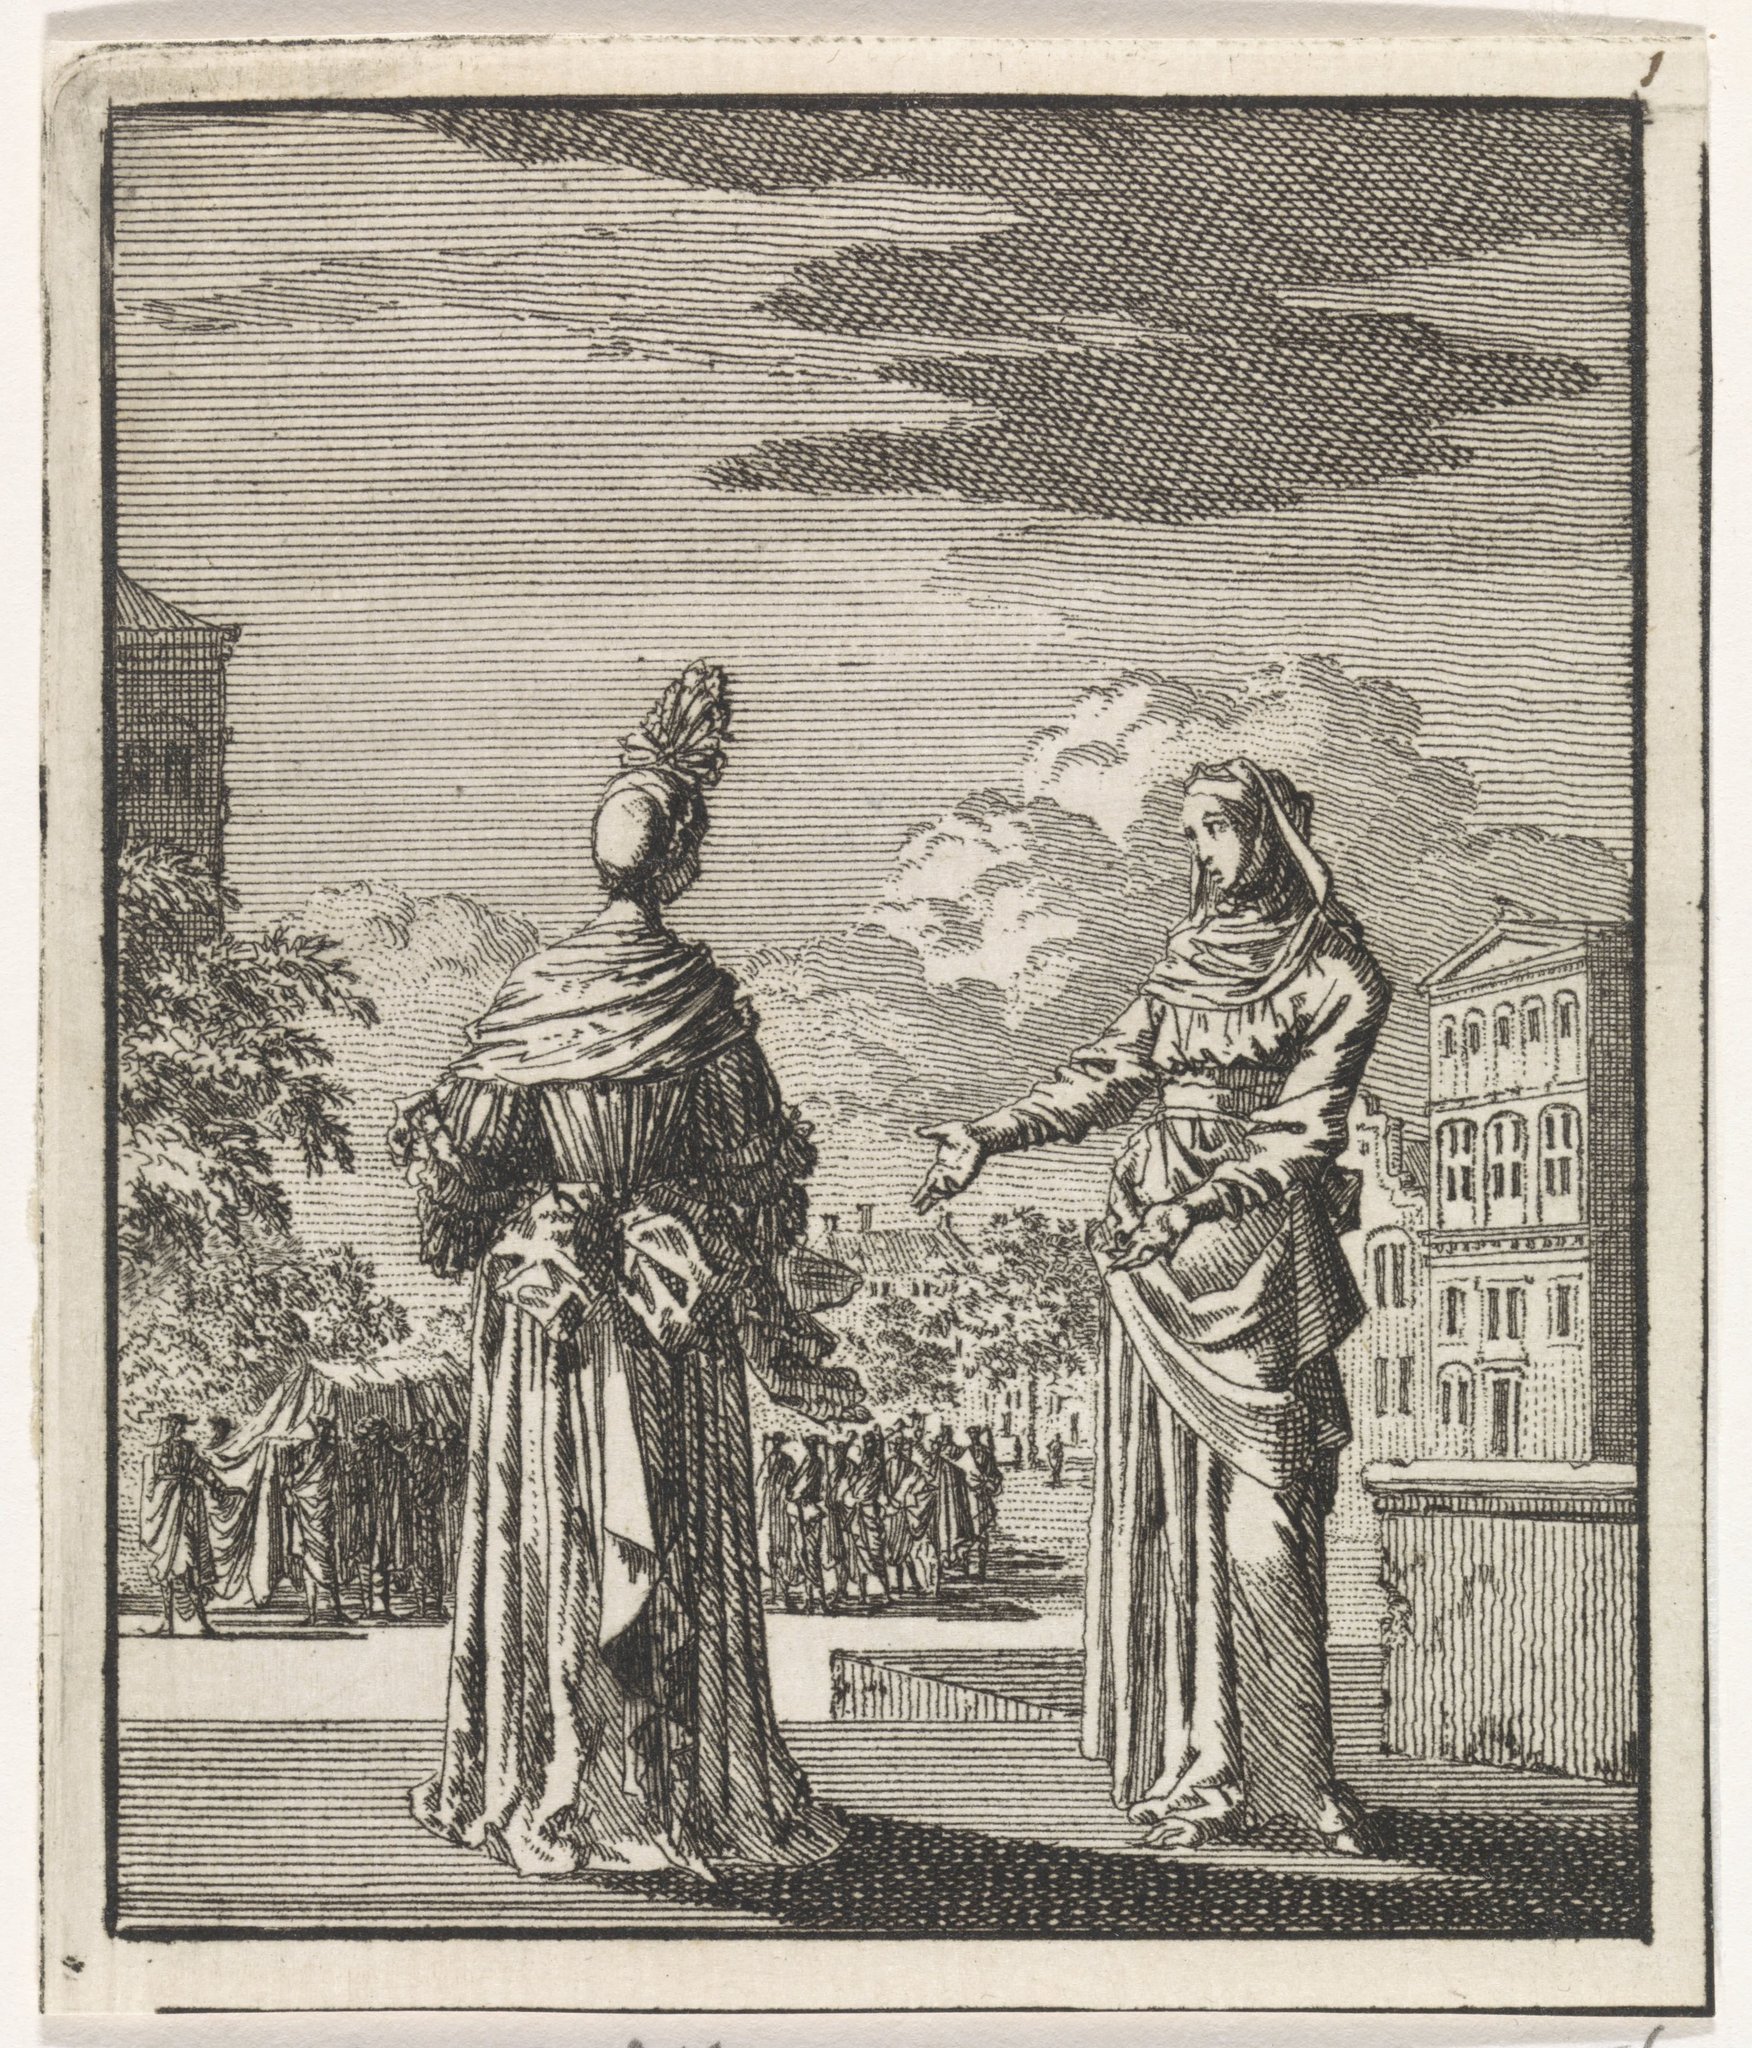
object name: print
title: Vrouw wijst dame op een voorbijtrekkende begrafenisstoet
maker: jan luyken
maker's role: draughtsman, print maker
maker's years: 1649-1712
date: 1704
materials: paper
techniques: etching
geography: amsterdam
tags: cortege, funeral procession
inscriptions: collector's mark: Lugt 2228, number: ‘1’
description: Proefdruk van illustratie uit: Luyken, Jan. De zedelyke en stichtelyke gezangen. Amsterdam: Wed. Pieter Arentsz (II) en Cornelis van der Sys, 1704, p. 1.